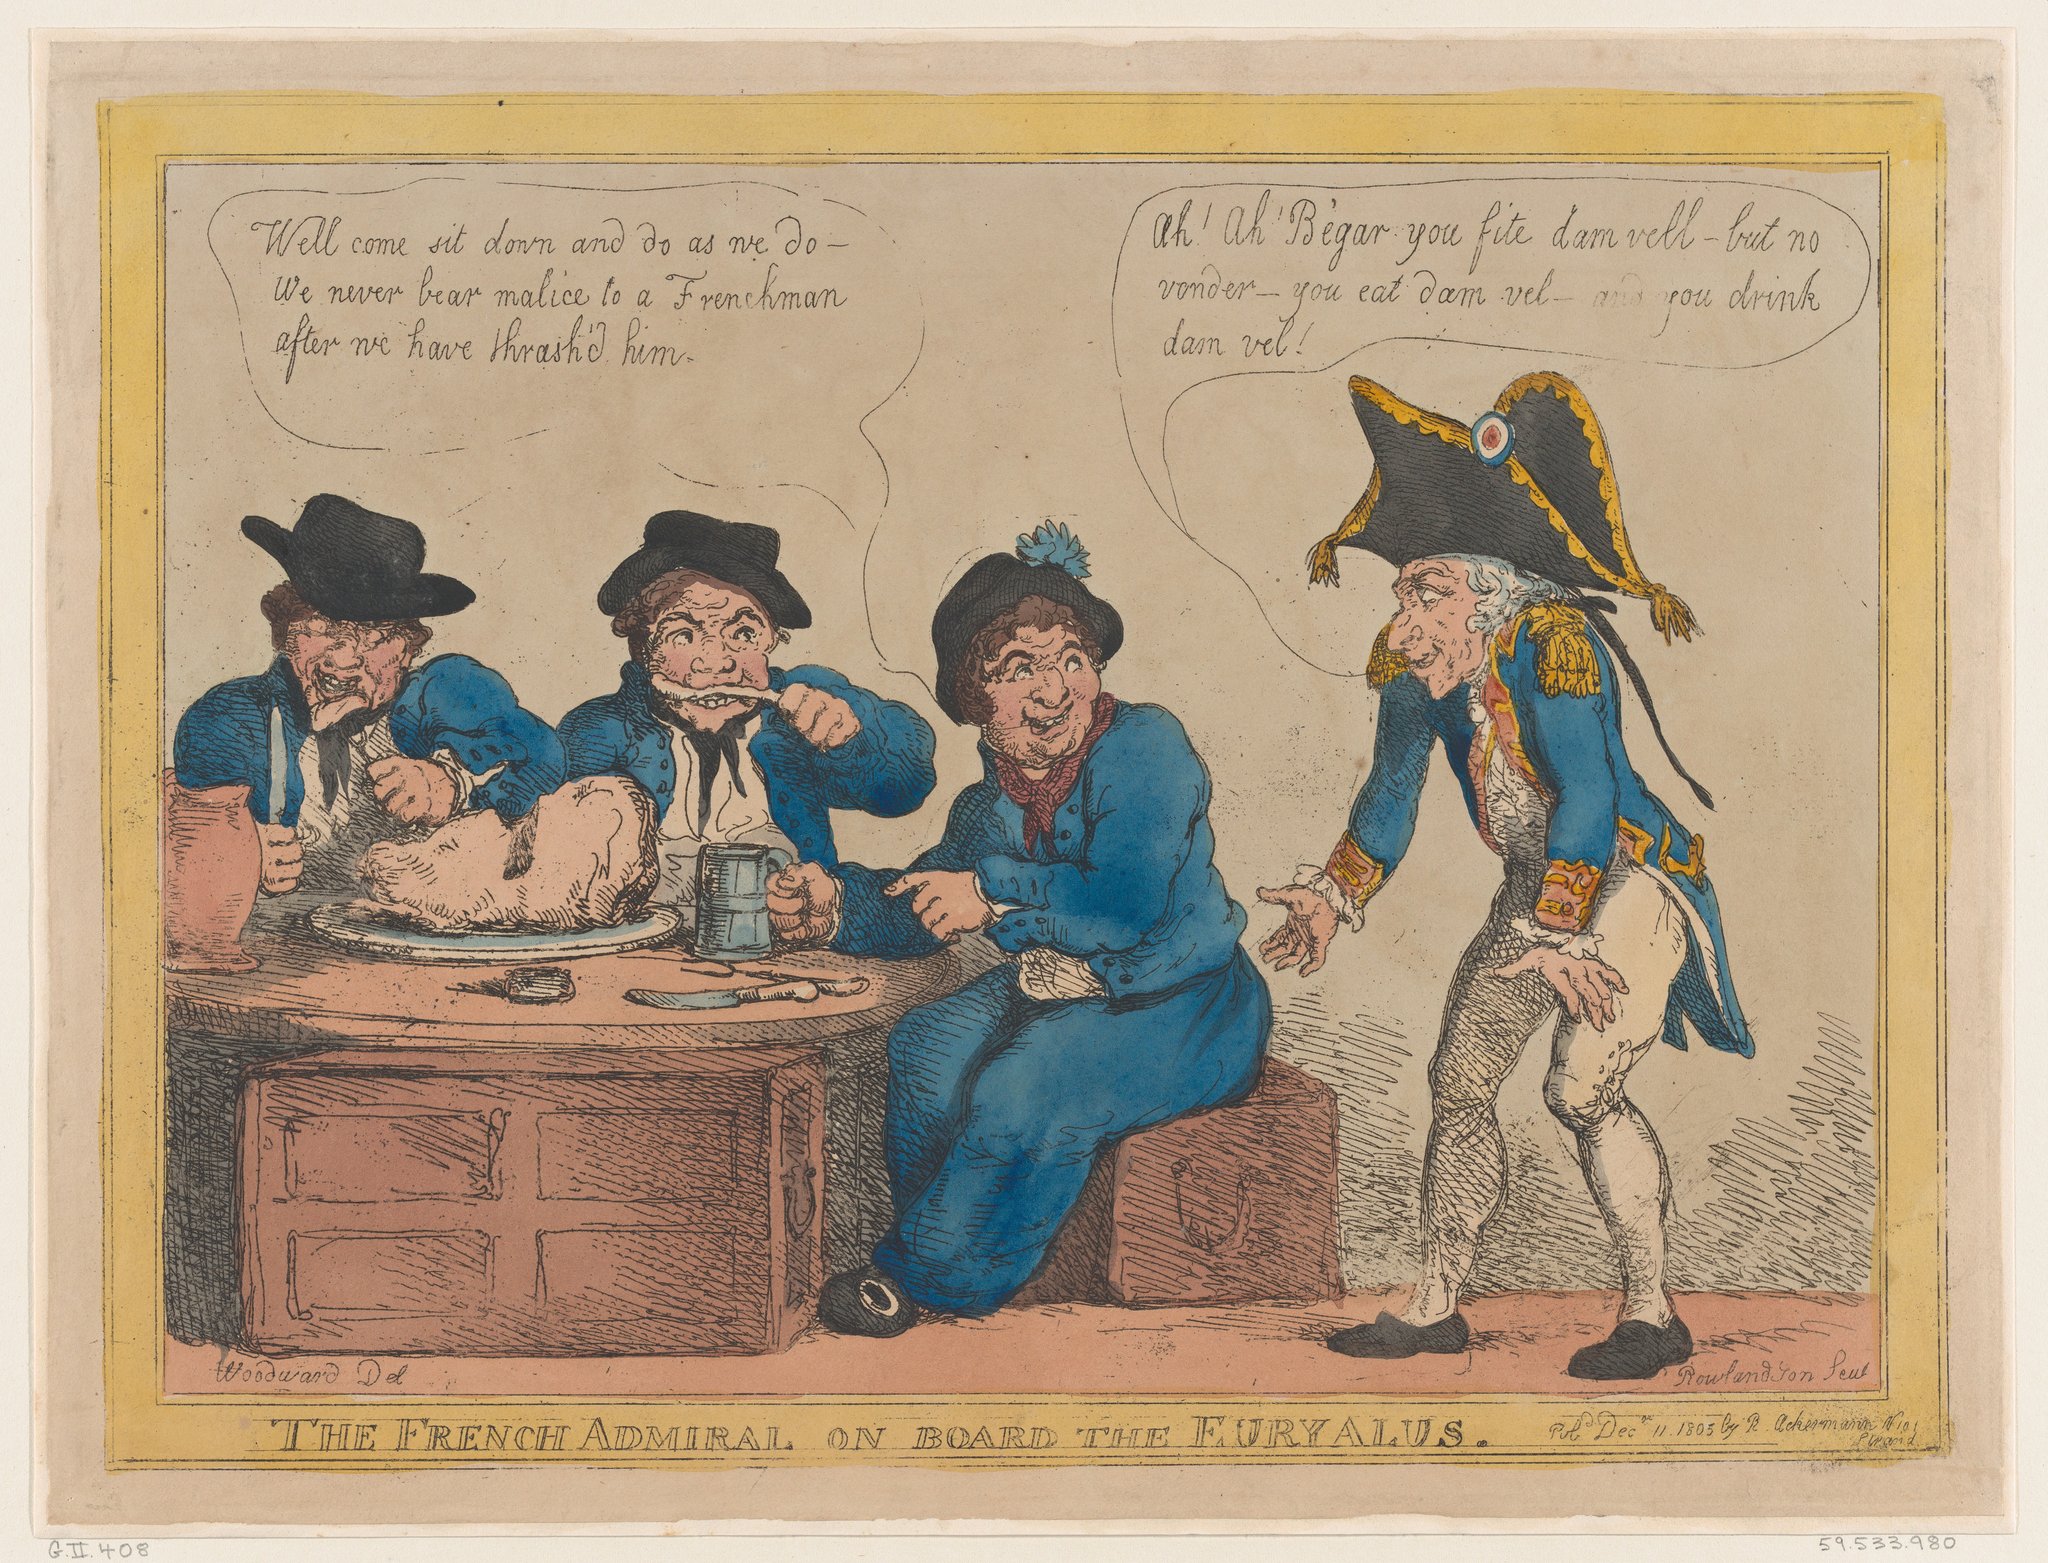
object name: print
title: The French Admiral on Board the Eryalus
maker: thomas rowlandson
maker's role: artist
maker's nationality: british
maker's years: 1757-1827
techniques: etching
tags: food,satire,men,dining,admirals